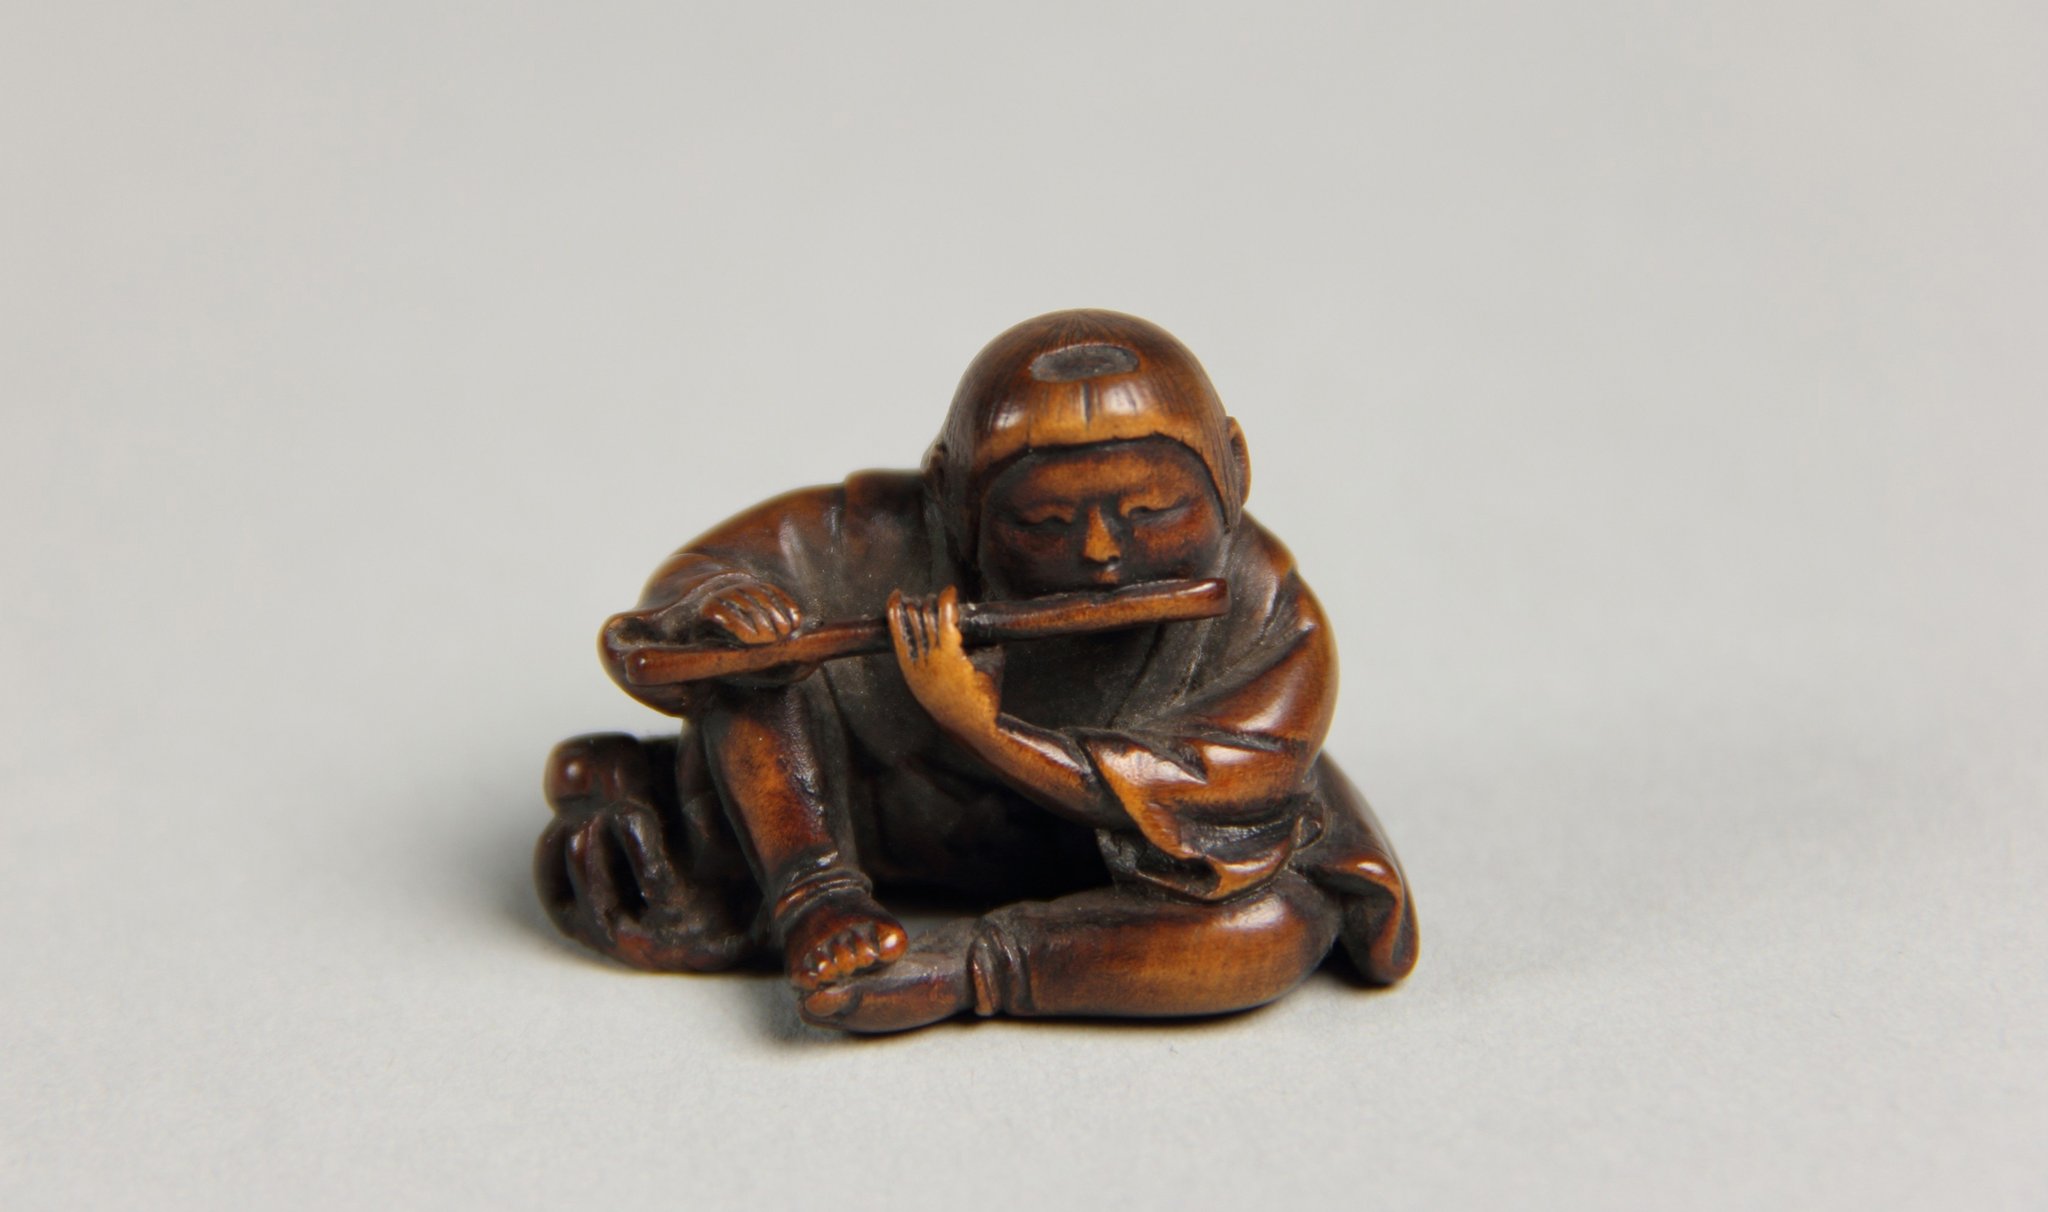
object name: netsuke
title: Netsuke of Boy Playing a Flute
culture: japanese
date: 1801-1900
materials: wood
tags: boys,flutes